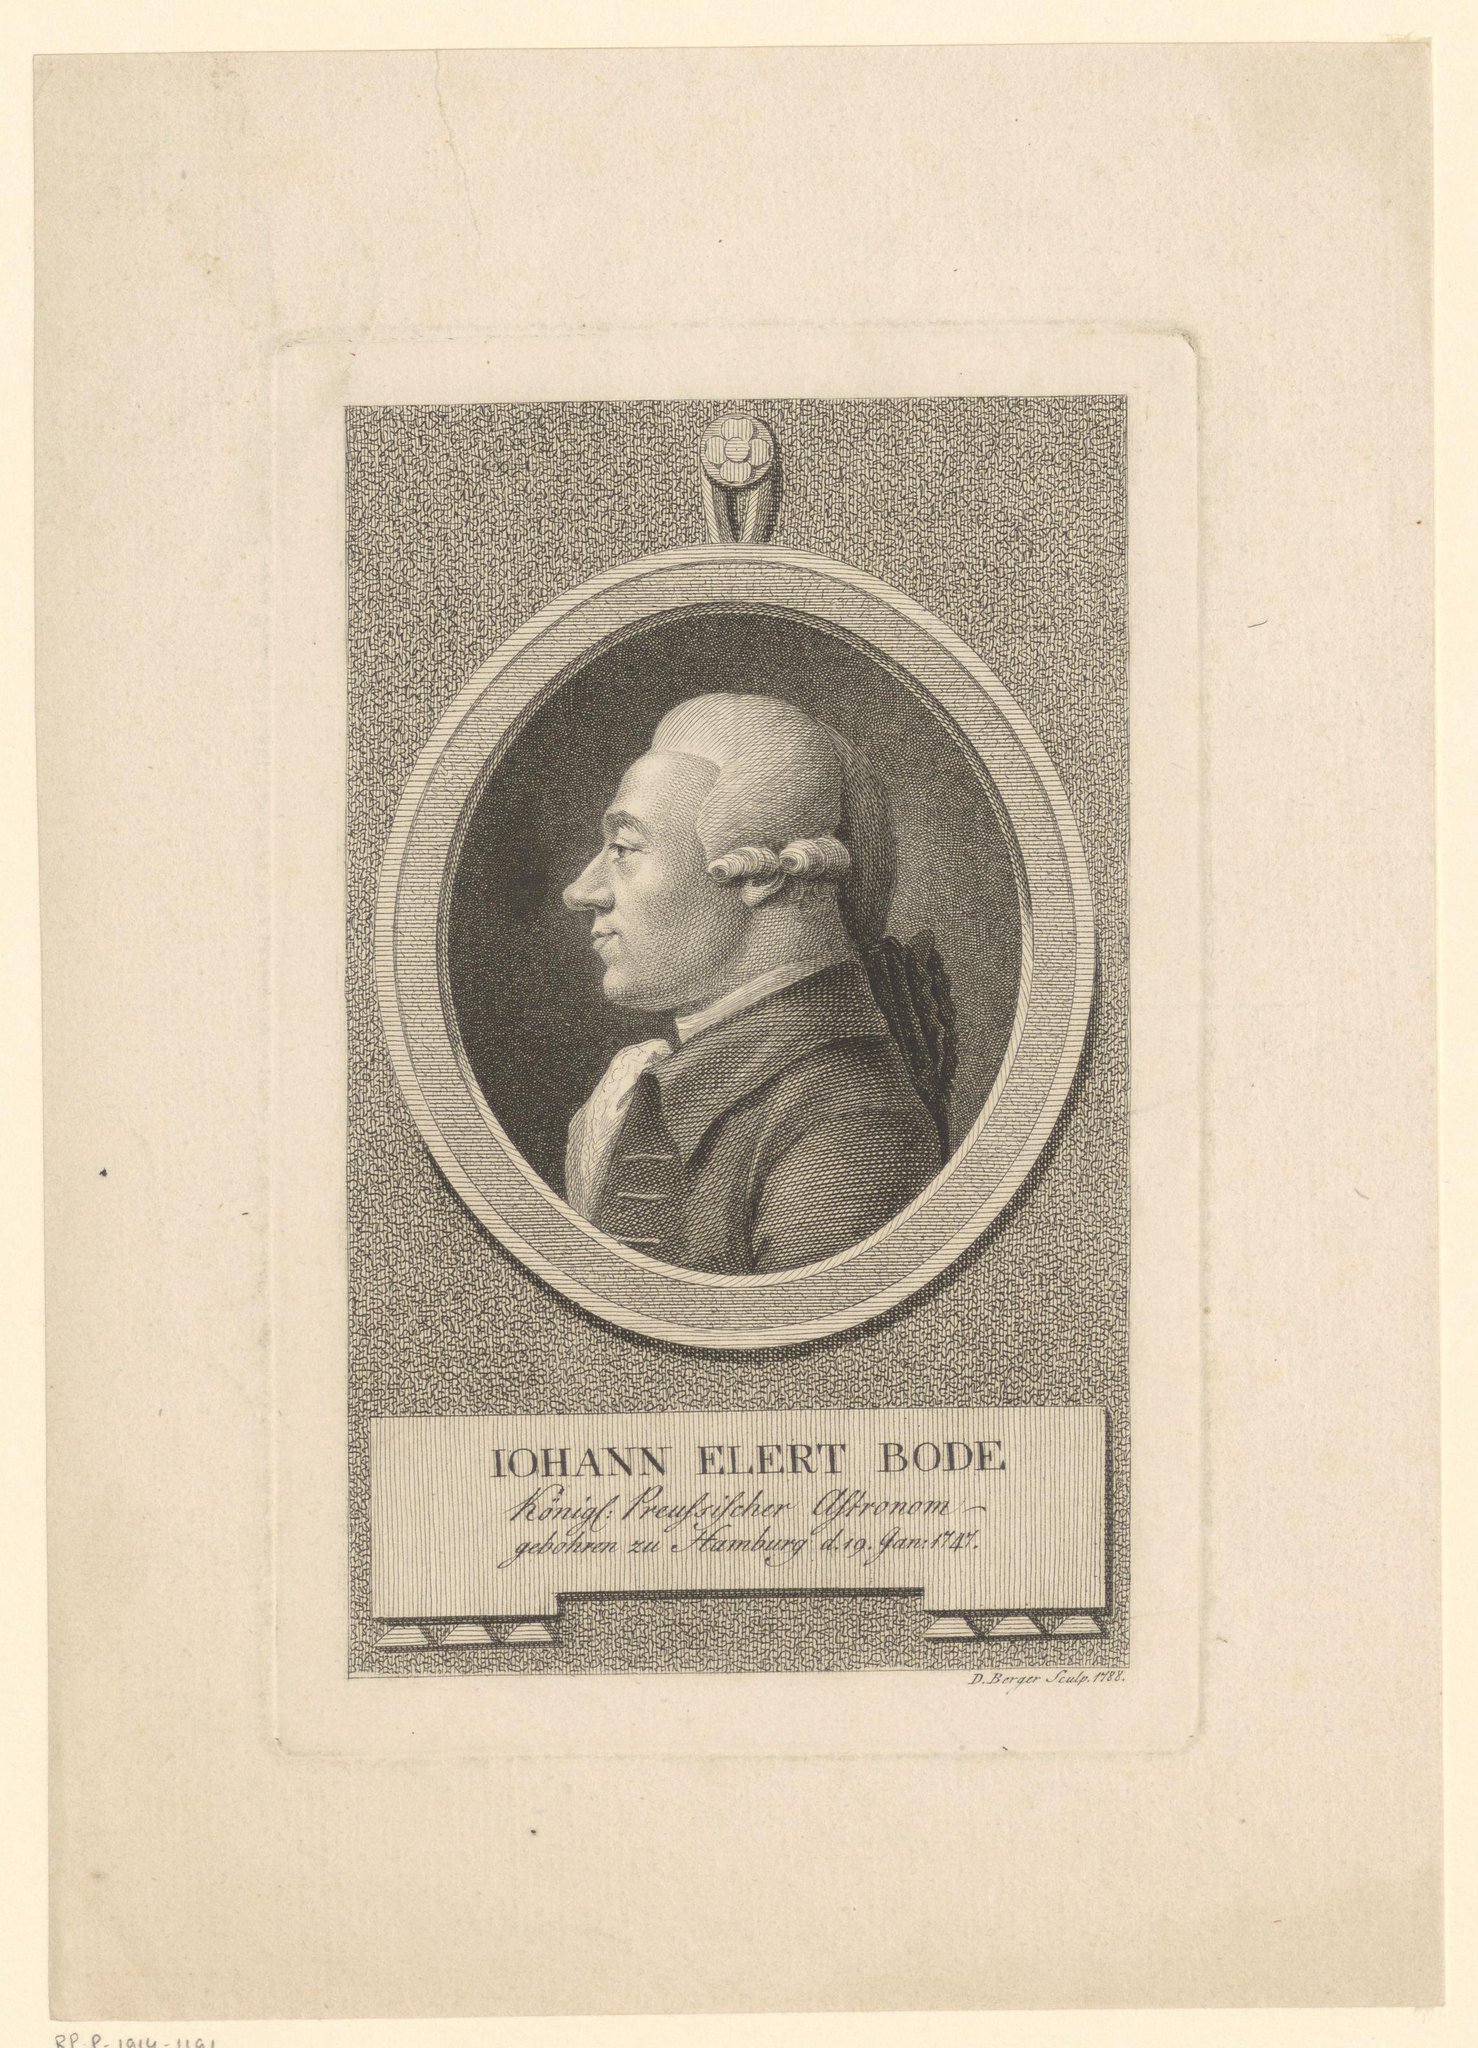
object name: print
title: Portret van Johann Elert Bode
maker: daniel berger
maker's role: print maker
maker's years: 1744-1824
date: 1788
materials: paper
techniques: etching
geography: berlin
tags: berlin, historical persons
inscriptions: collector's mark: Lugt 2228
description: Prent ook gebruikt in: Bode, Johann Elert. Anleitung zur Kenntniß des Gestirnten Himmels. Berlijn: Crhistian Friedrich Himburg, 1788 [vijfde editie].